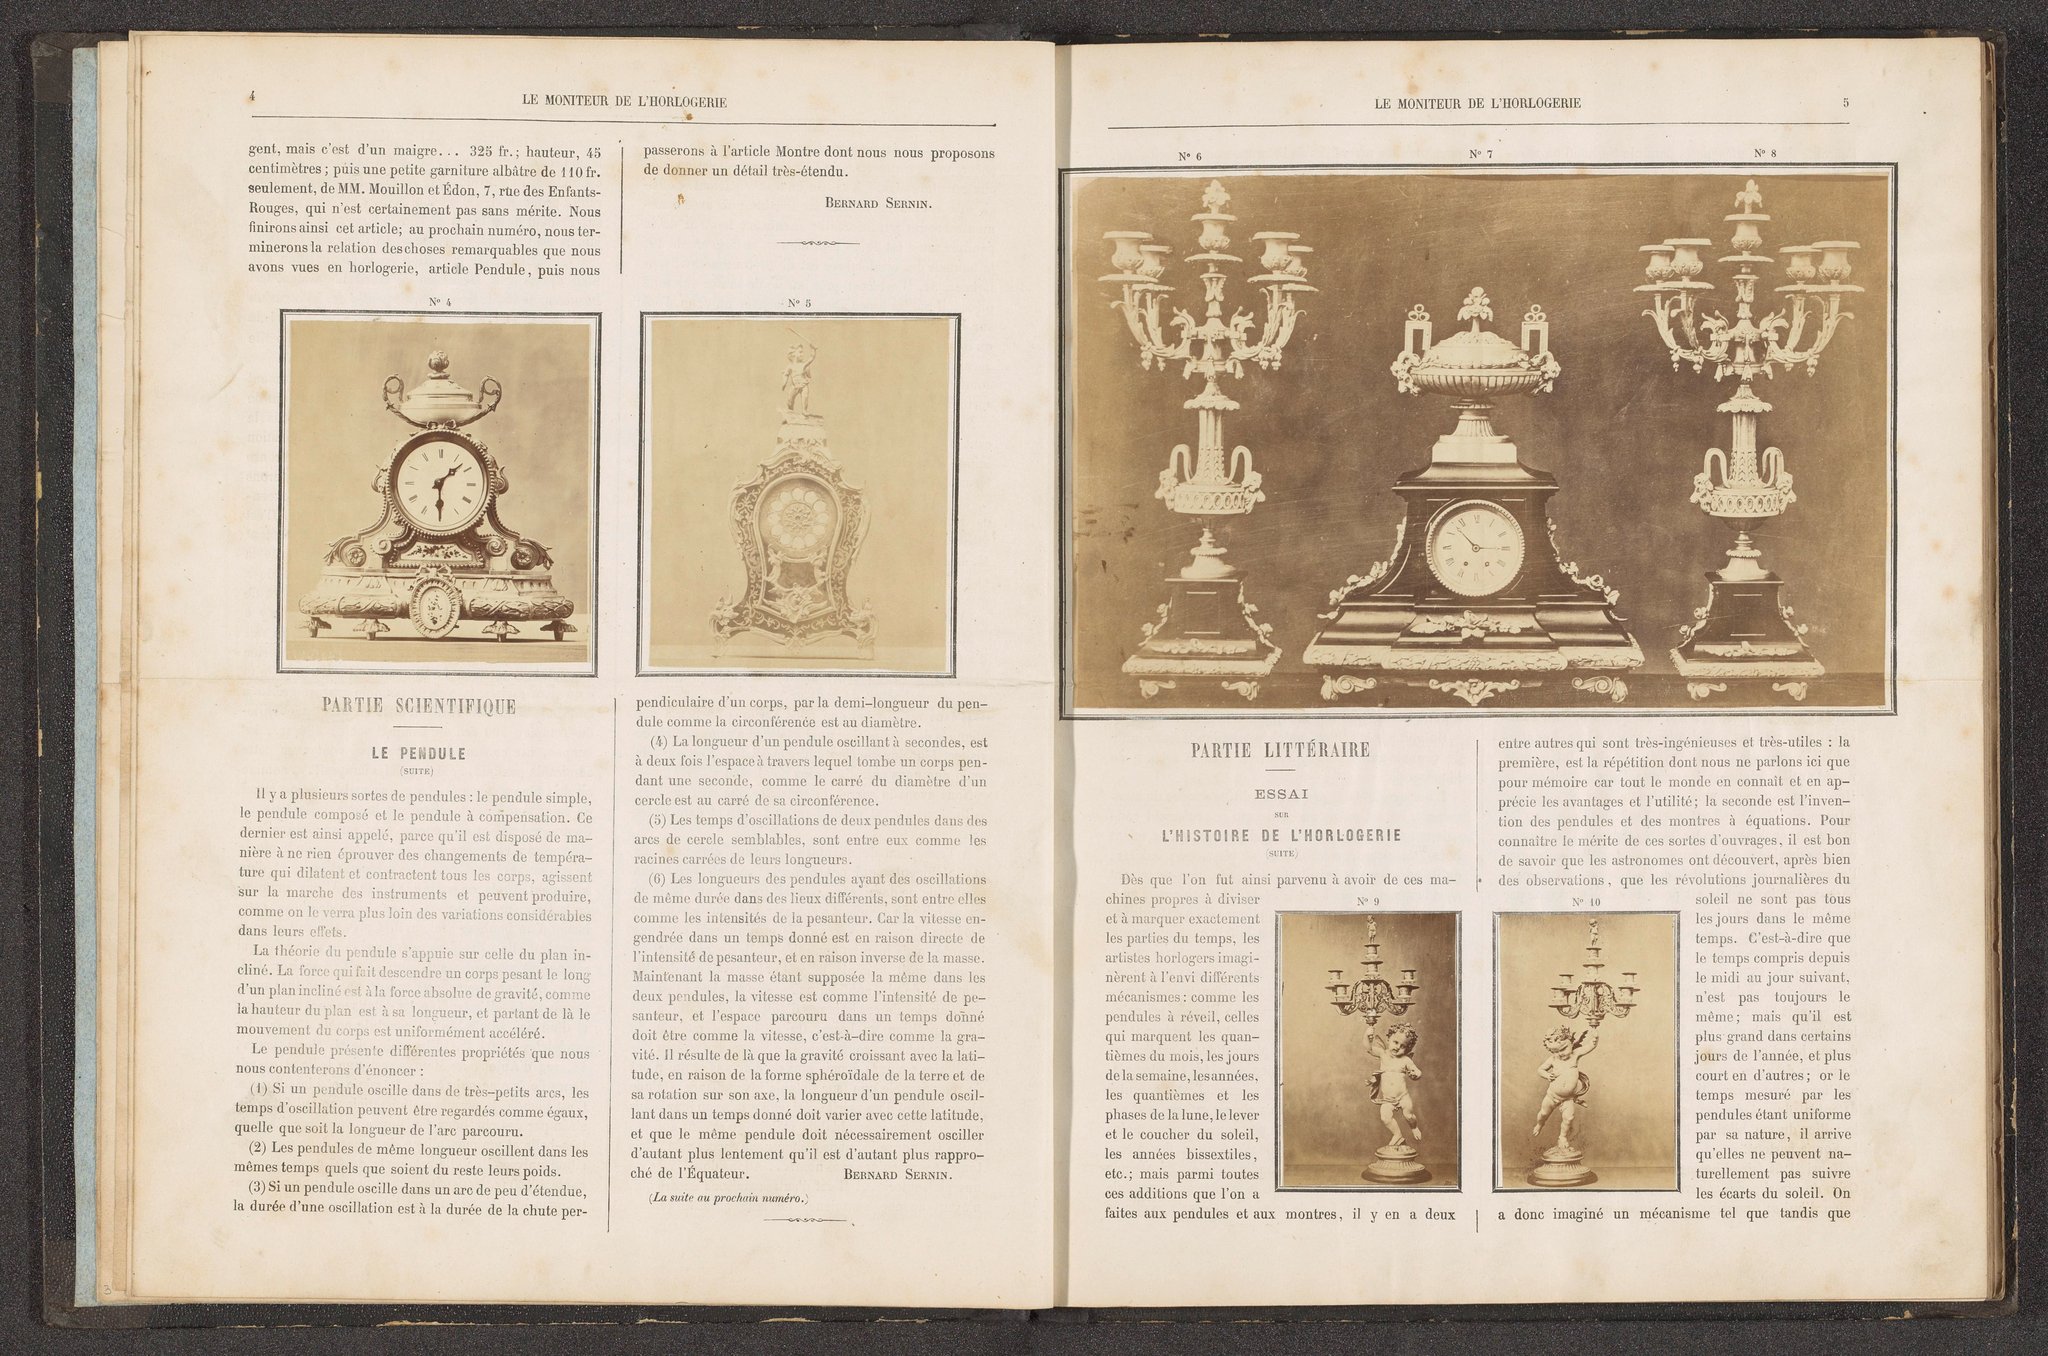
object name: photograph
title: Vier kandelaren en een klok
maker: Anonymous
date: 1857-1867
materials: photographic support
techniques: albumen print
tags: clock, candlestick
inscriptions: number: ‘No 6 No 7 No 8 No 9 N0 10’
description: Boven: klok met twee kandelaren door M. Dhénain, onder: twee kandelaren gedecoreerd met putti door MM. Valdun et Cie.